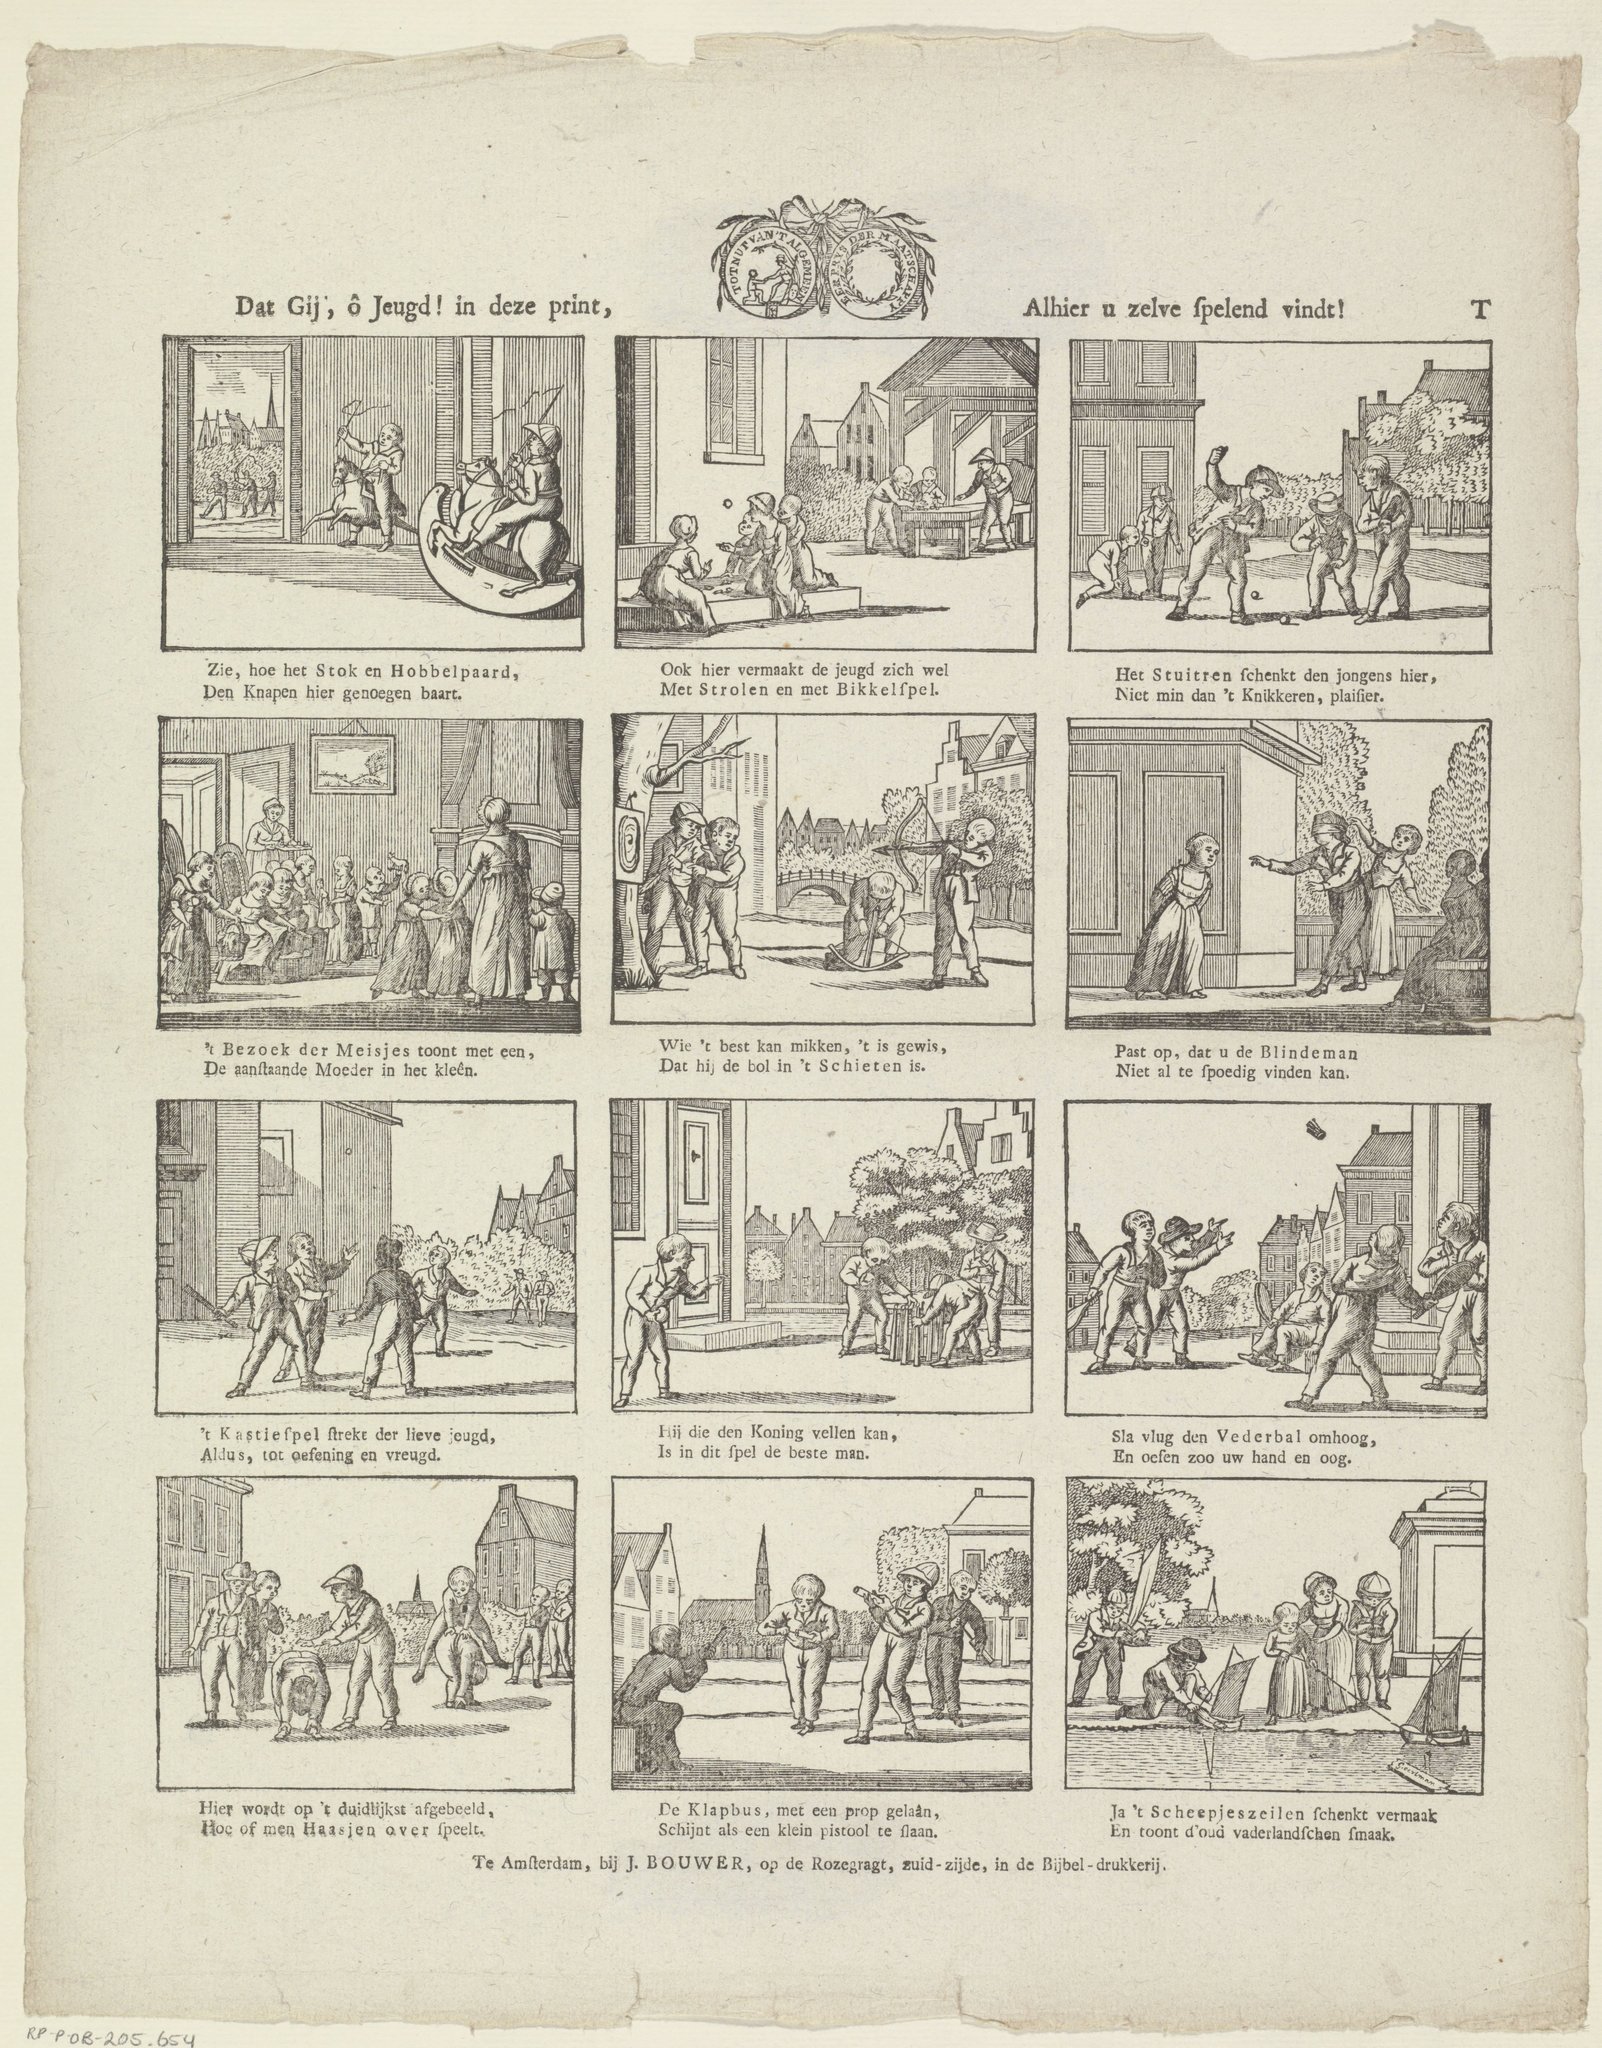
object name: popular print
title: Dat gij, ô jeugd! in deze print, / Alhier u zelve spelend vindt!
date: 1805-1808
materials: paper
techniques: letterpress printing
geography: amsterdam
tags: children's games and plays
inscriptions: collector's mark: Lugt 2760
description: Blad met 12 voorstellingen van kinderspelen. Midden boven het zegel van de Maatschappij tot Nut van 't Algemeen. Onder elke afbeelding een tweeregelig vers. Genummerd rechtsboven: T.